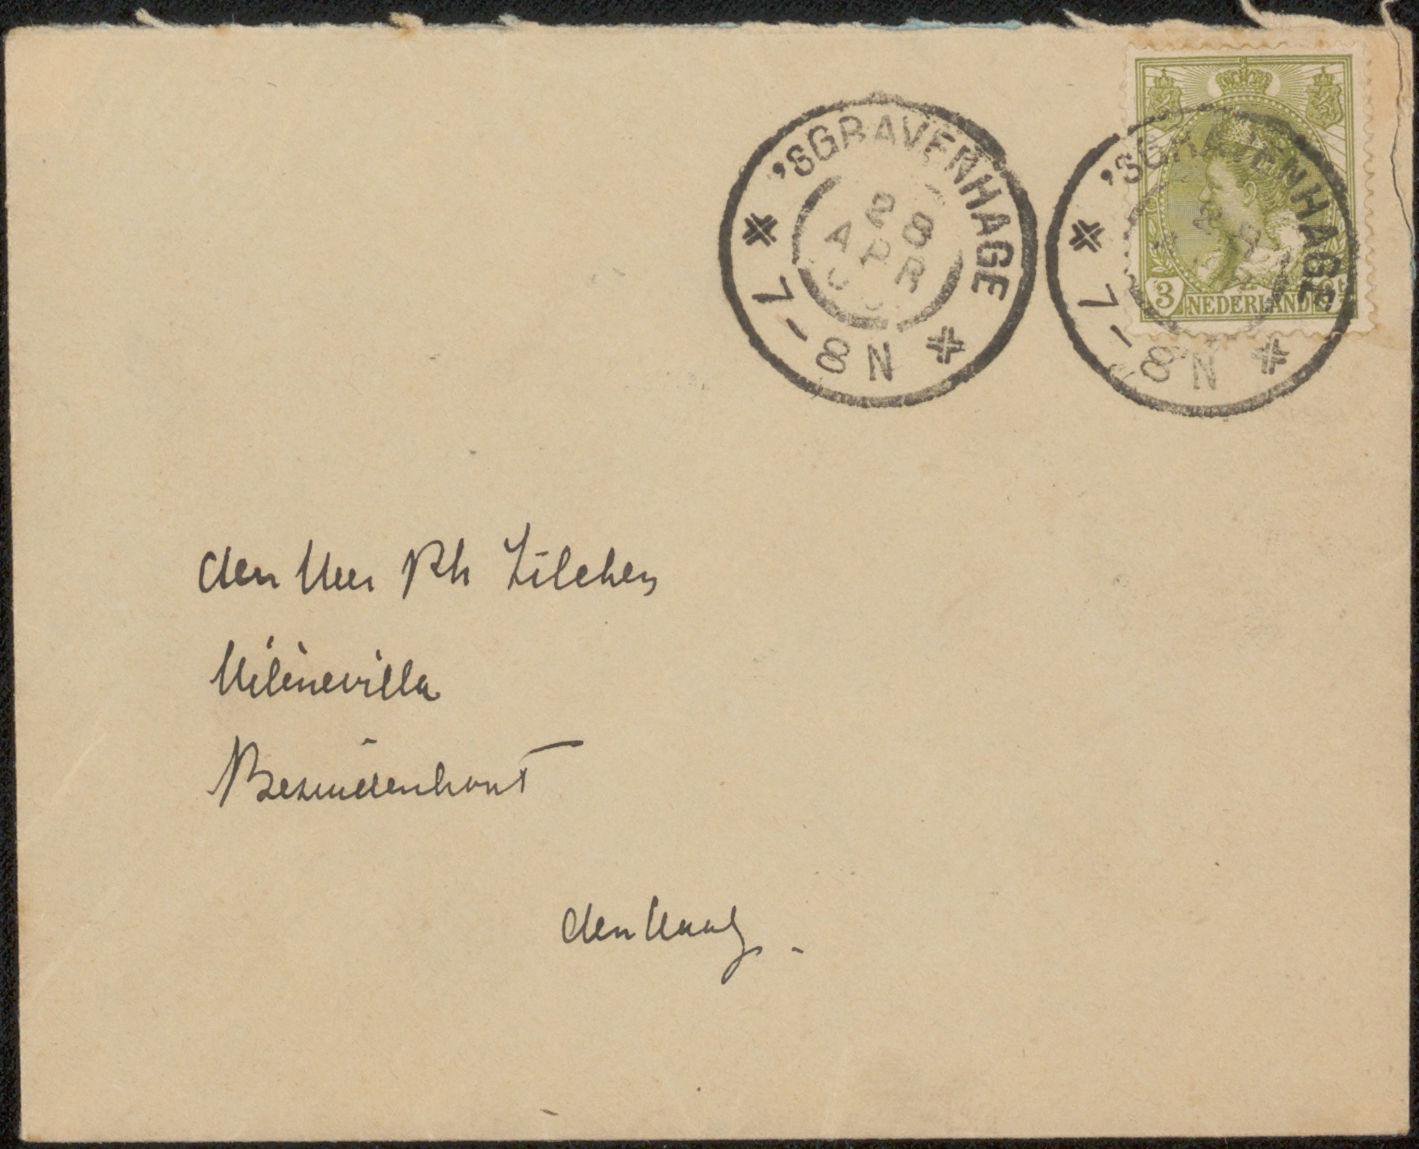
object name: letter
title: Brief aan Philip Zilcken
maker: grada hermina marius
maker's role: painter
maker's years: 1854-1919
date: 1903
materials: ink, paper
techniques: pen, writing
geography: the hague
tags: amsterdam, rembrandt van rijn, the hague, painter, philip zilcken, exhibition ~ art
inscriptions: collector's mark: ‘RPK’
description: RP-D-1982-43-MARIUS(G.H.)-38 is geschreven op de achterkant van RP-D-1982-43-MARIUS(G.H.)-19A.